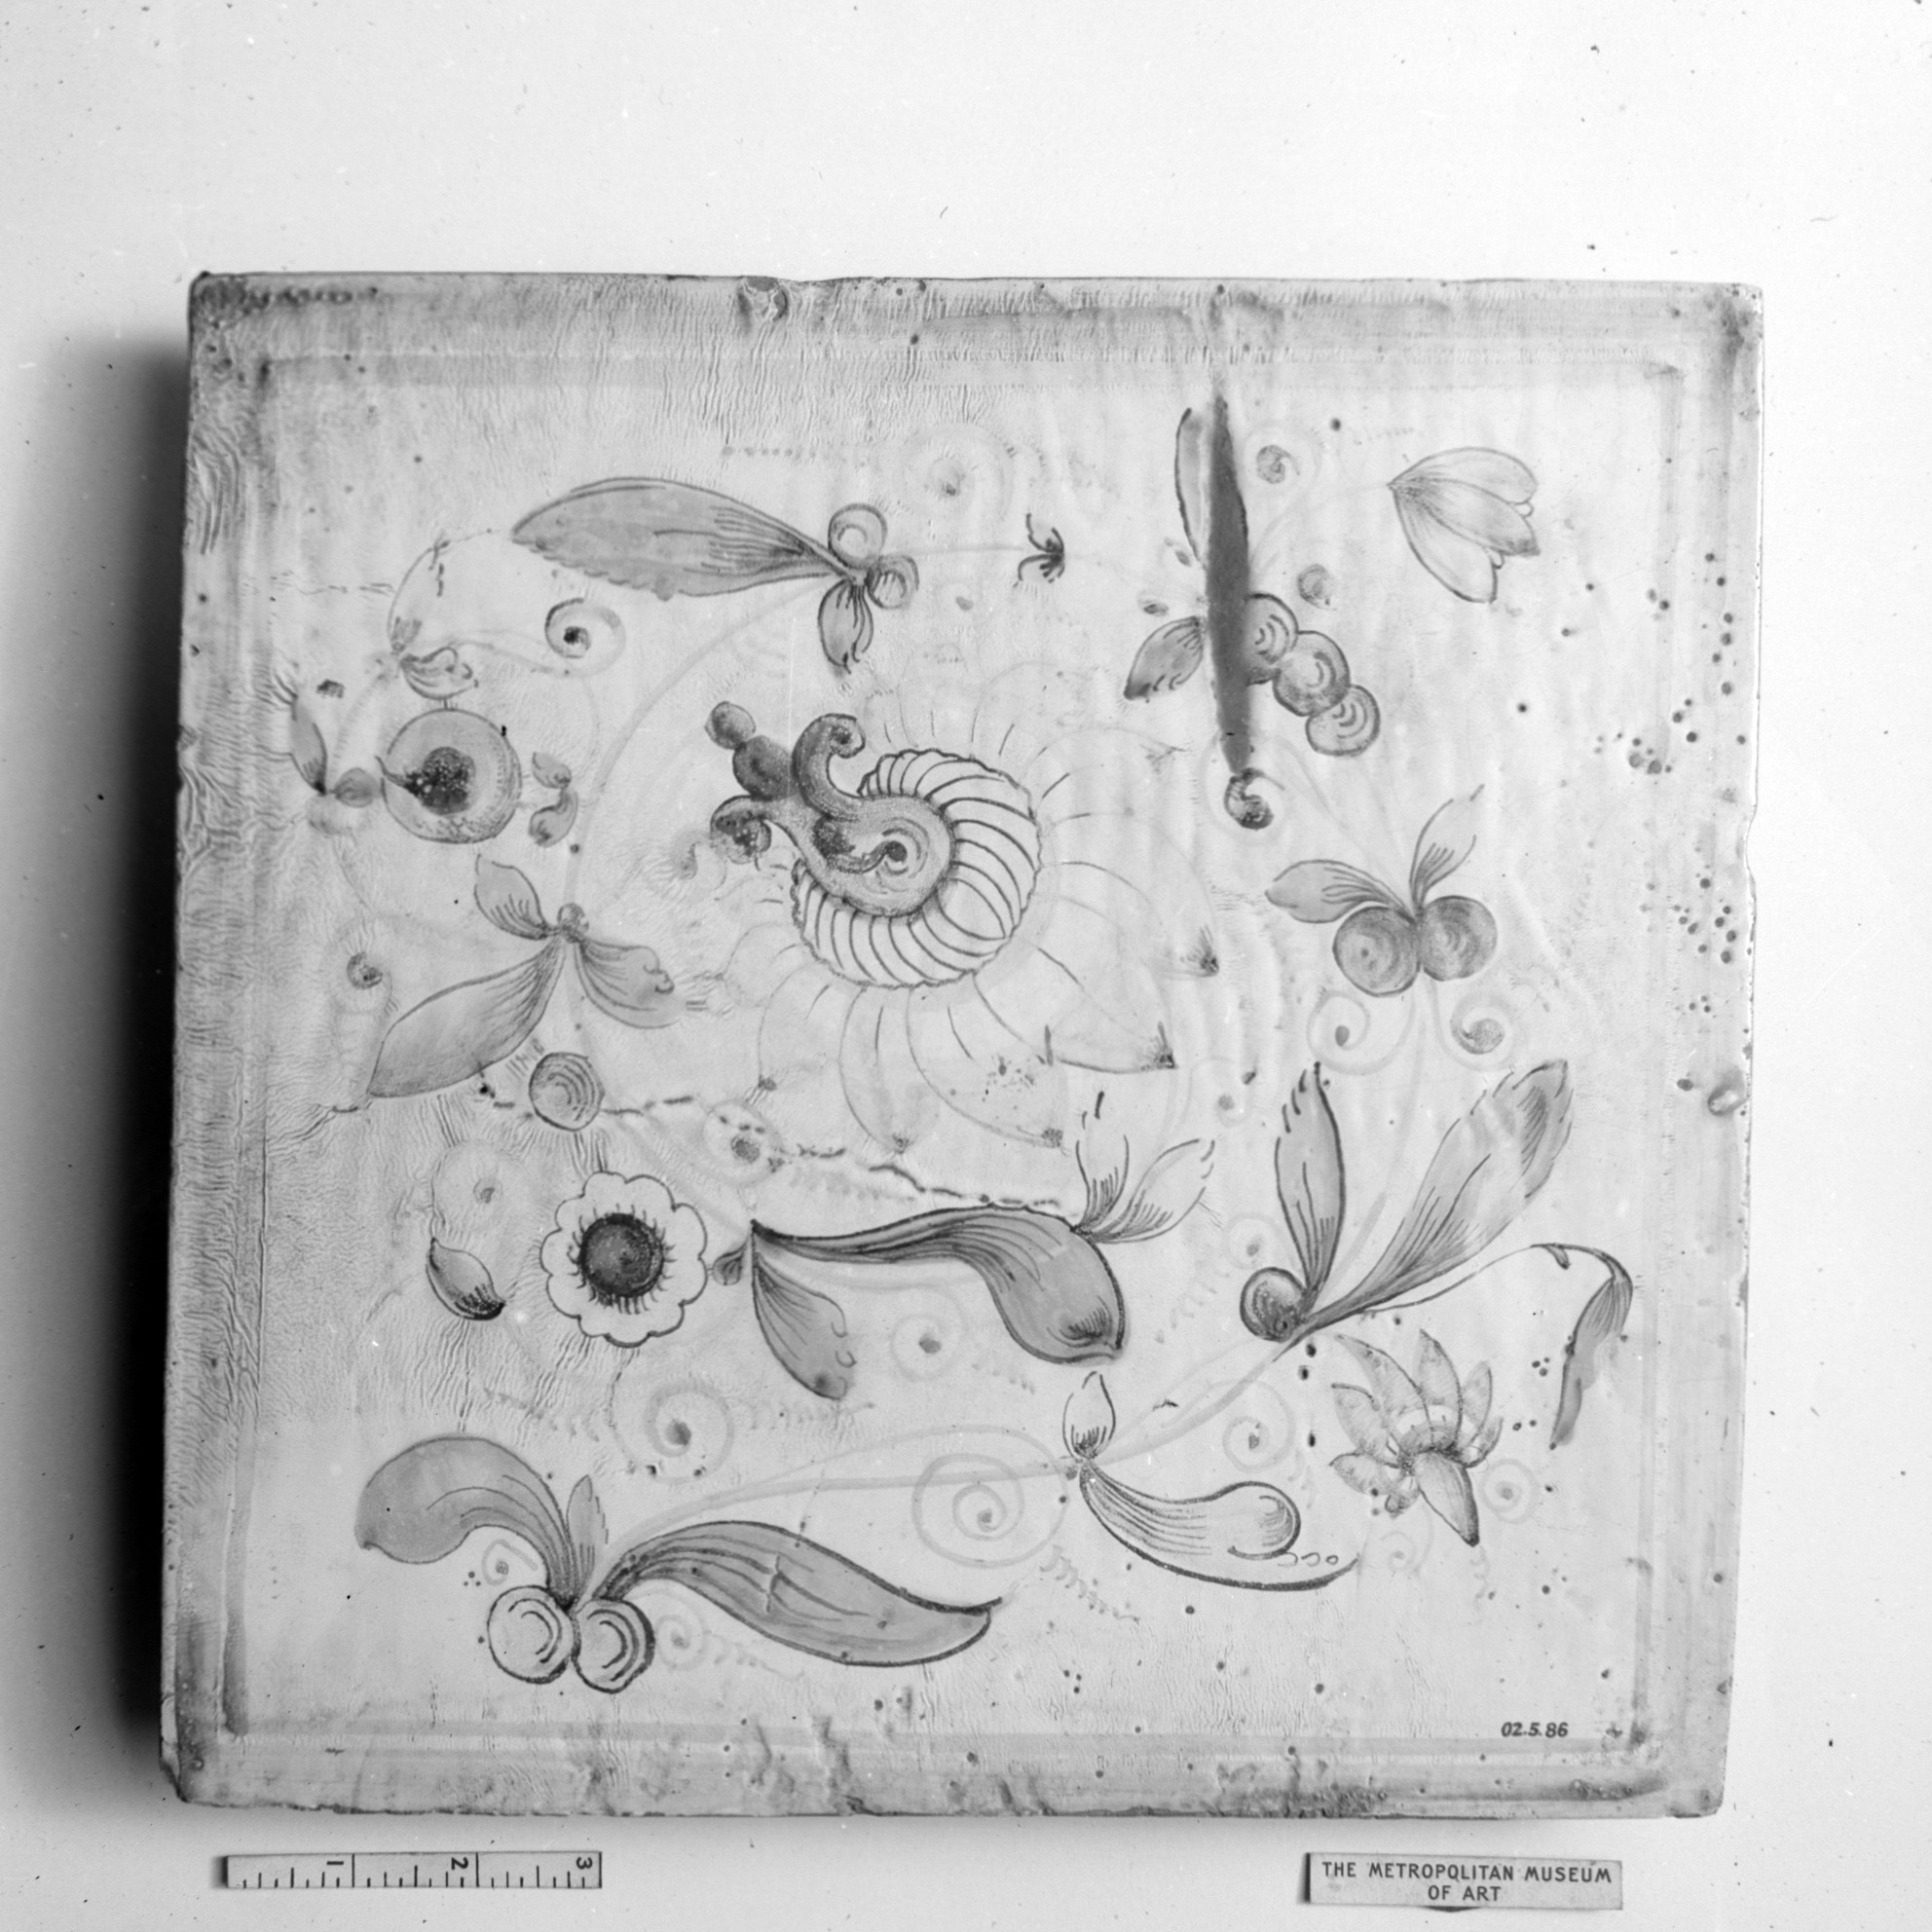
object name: tile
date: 1601-1700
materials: earthenware